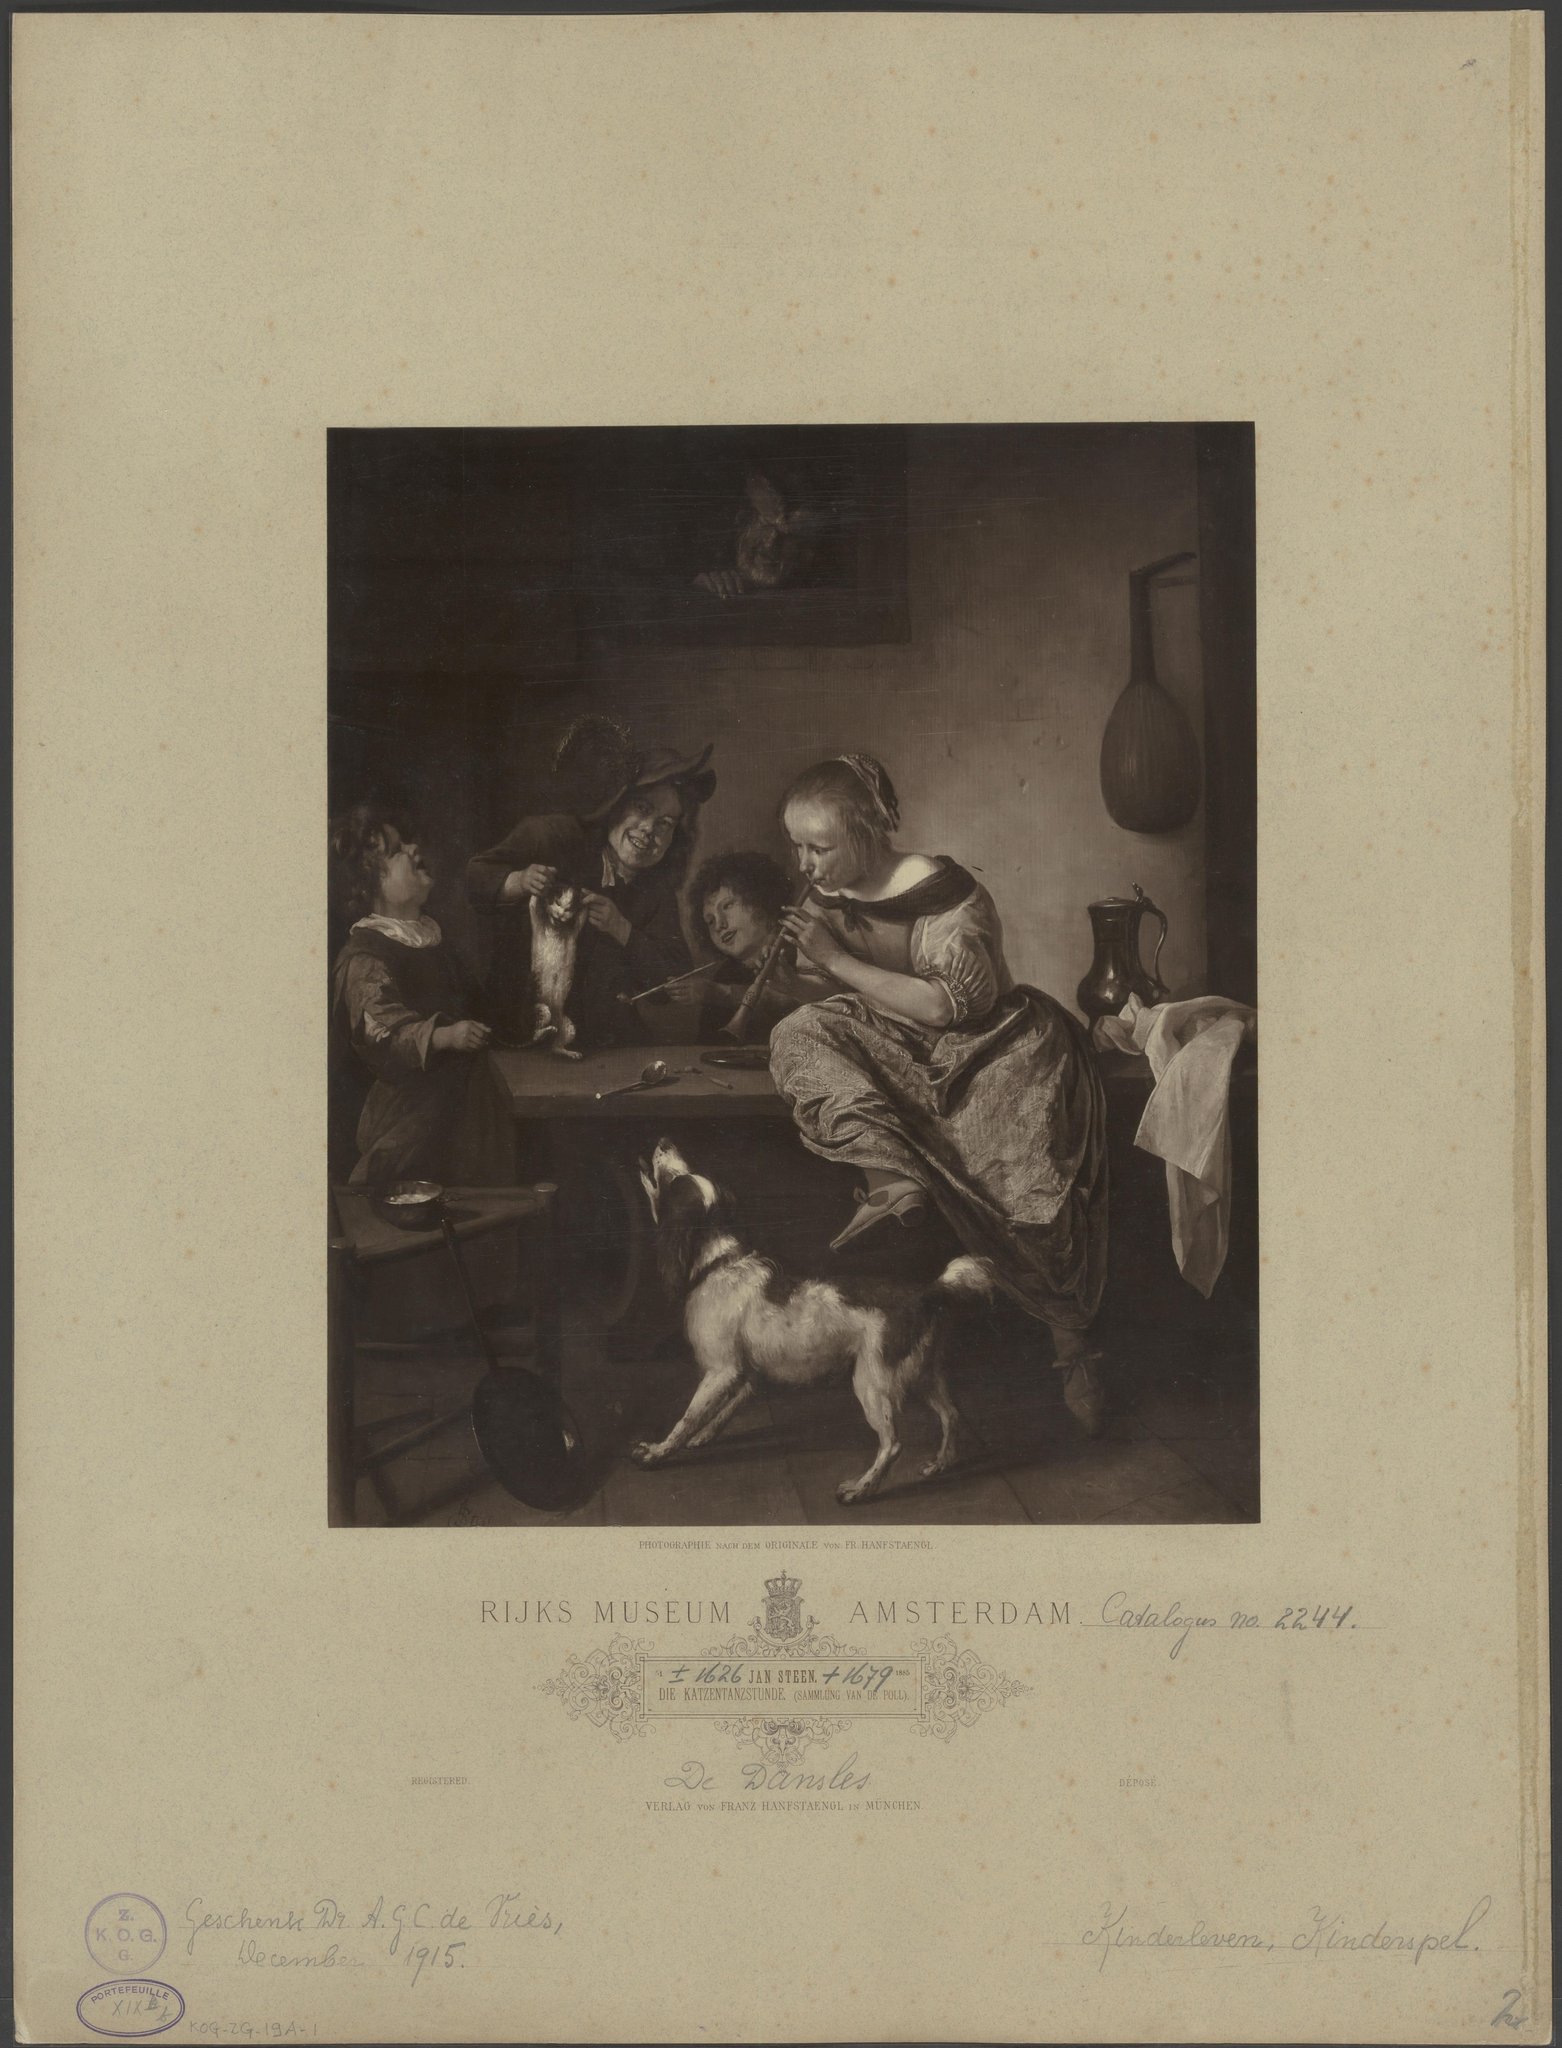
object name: print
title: Kinderen leren een poes dansen, bekend als ‘De dansles’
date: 1804-1877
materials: cardboard, paper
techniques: photolithography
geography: munich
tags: cat, children playing musical instruments, child playing with animals, dog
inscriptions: : ‘registrered / déposé’, collector's mark: Lugt 1641, stamp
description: Een groep kinderen probeert een kat te laten dansen; een voorstelling bekend als 'De dansles'. De kinderen zitten rond een tafel, een meisje speelt op een fluit, de hond blaft. Boven kijkt een man door een raampje toe, rechts hangt een luit aan de muur. Onderwerpsrubrieken binnen de Atlas Zeden en Gewoonten: Zeden en Gewoonten in Engeren Zin, Des menschen beging, midden en einde, Kinderleven – Kinderspel en Kinderprenten.